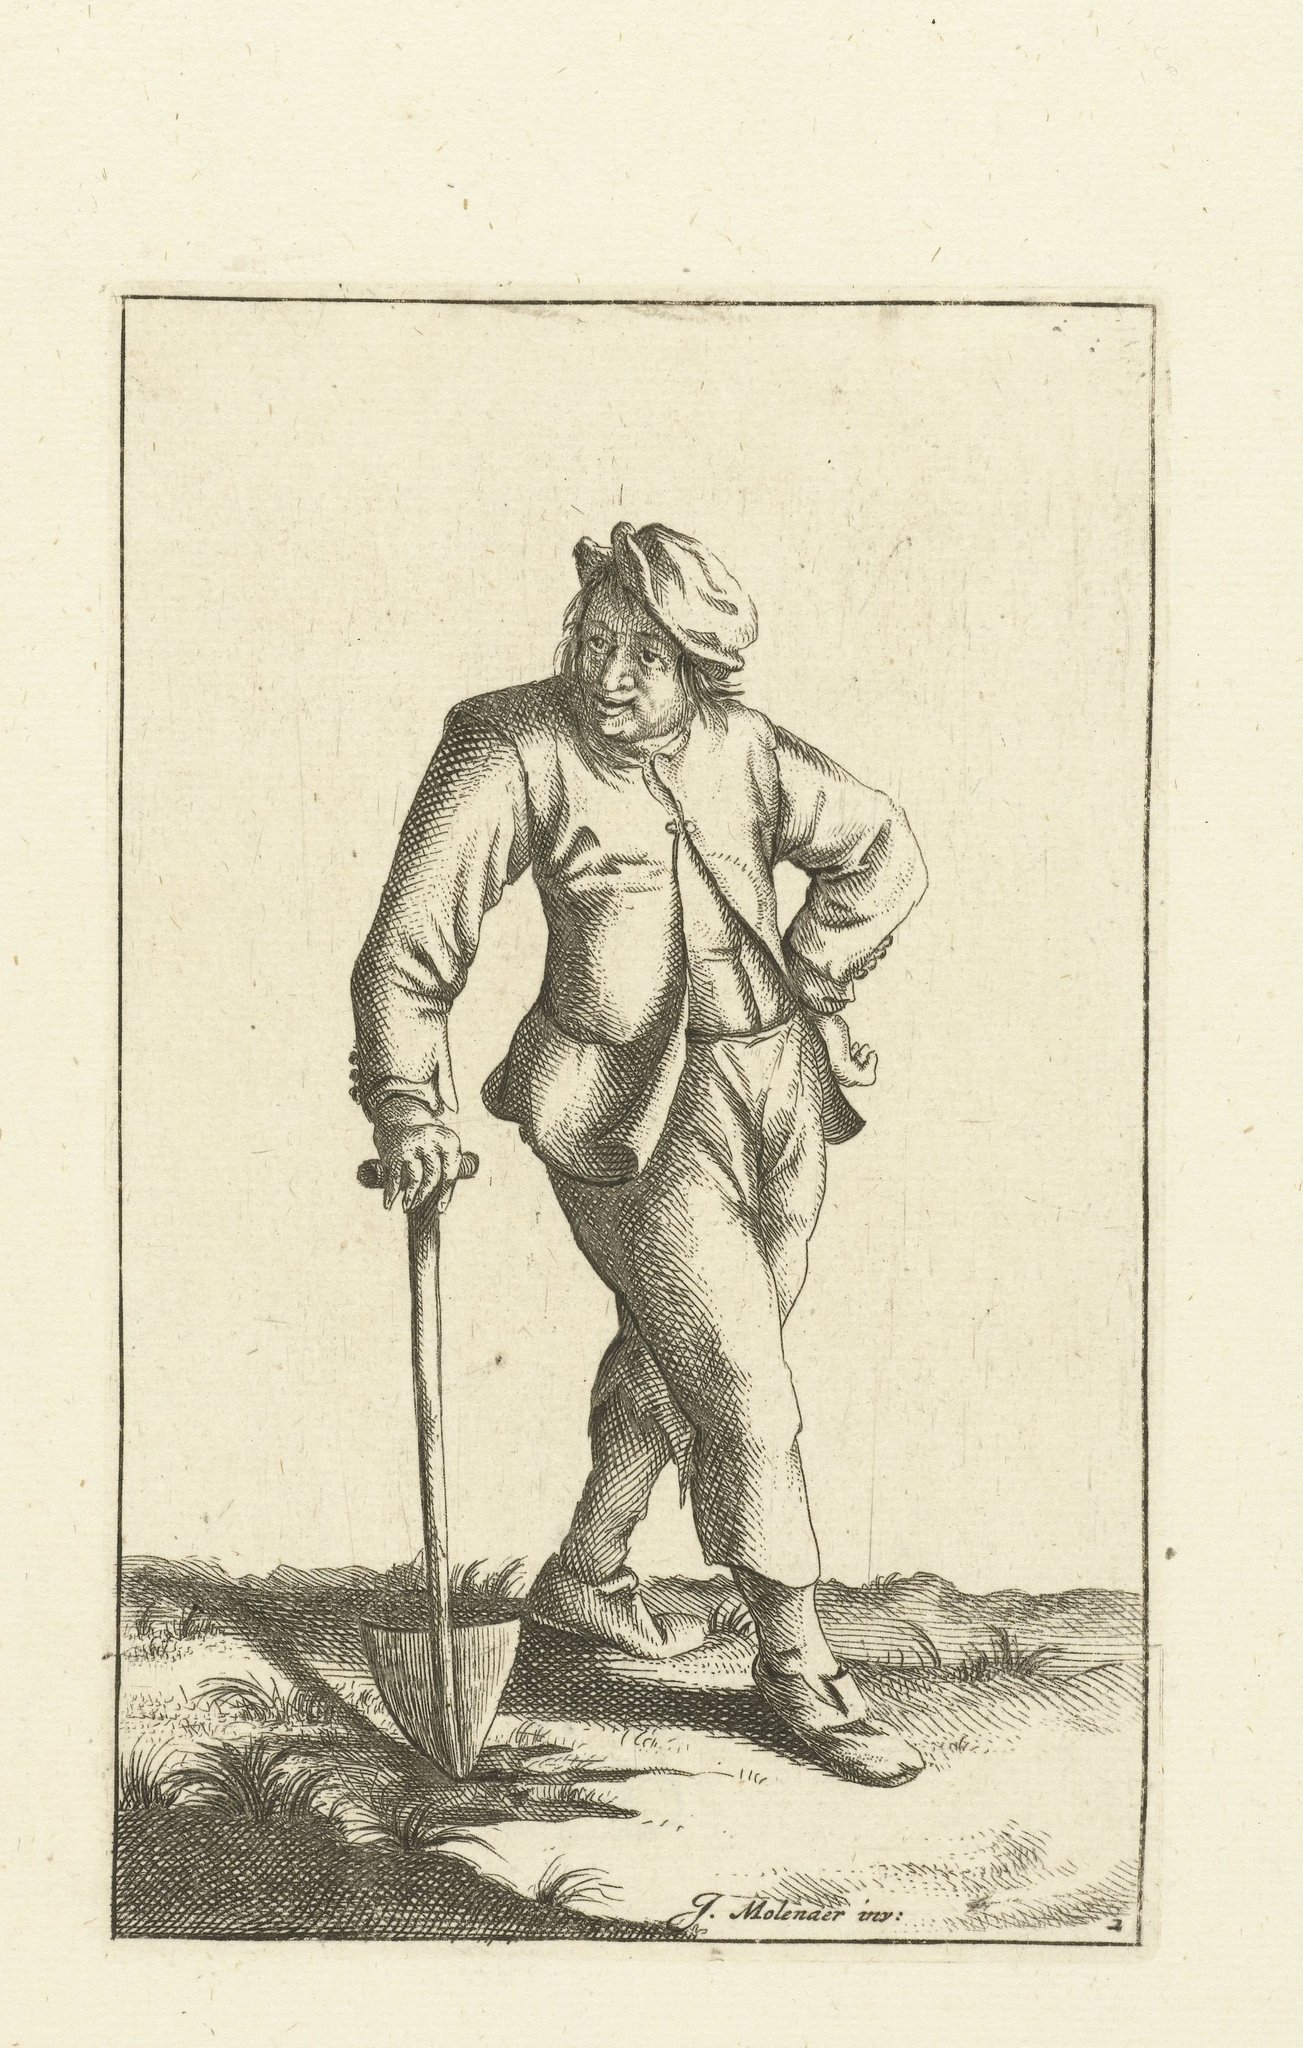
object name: print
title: Enige boeren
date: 1613-1656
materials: paper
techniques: etching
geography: netherlands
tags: farmers, agricultural implements: spade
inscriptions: collector's mark: Lugt 2228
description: Prent uit serie van zes prenten met boeren naar verschillende kunstenaars: Jan Miense Molenaer, Pieter Quast, Hendrik Potuyl en Adriaen van Ostade